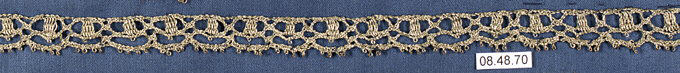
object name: fragment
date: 1830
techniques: lace